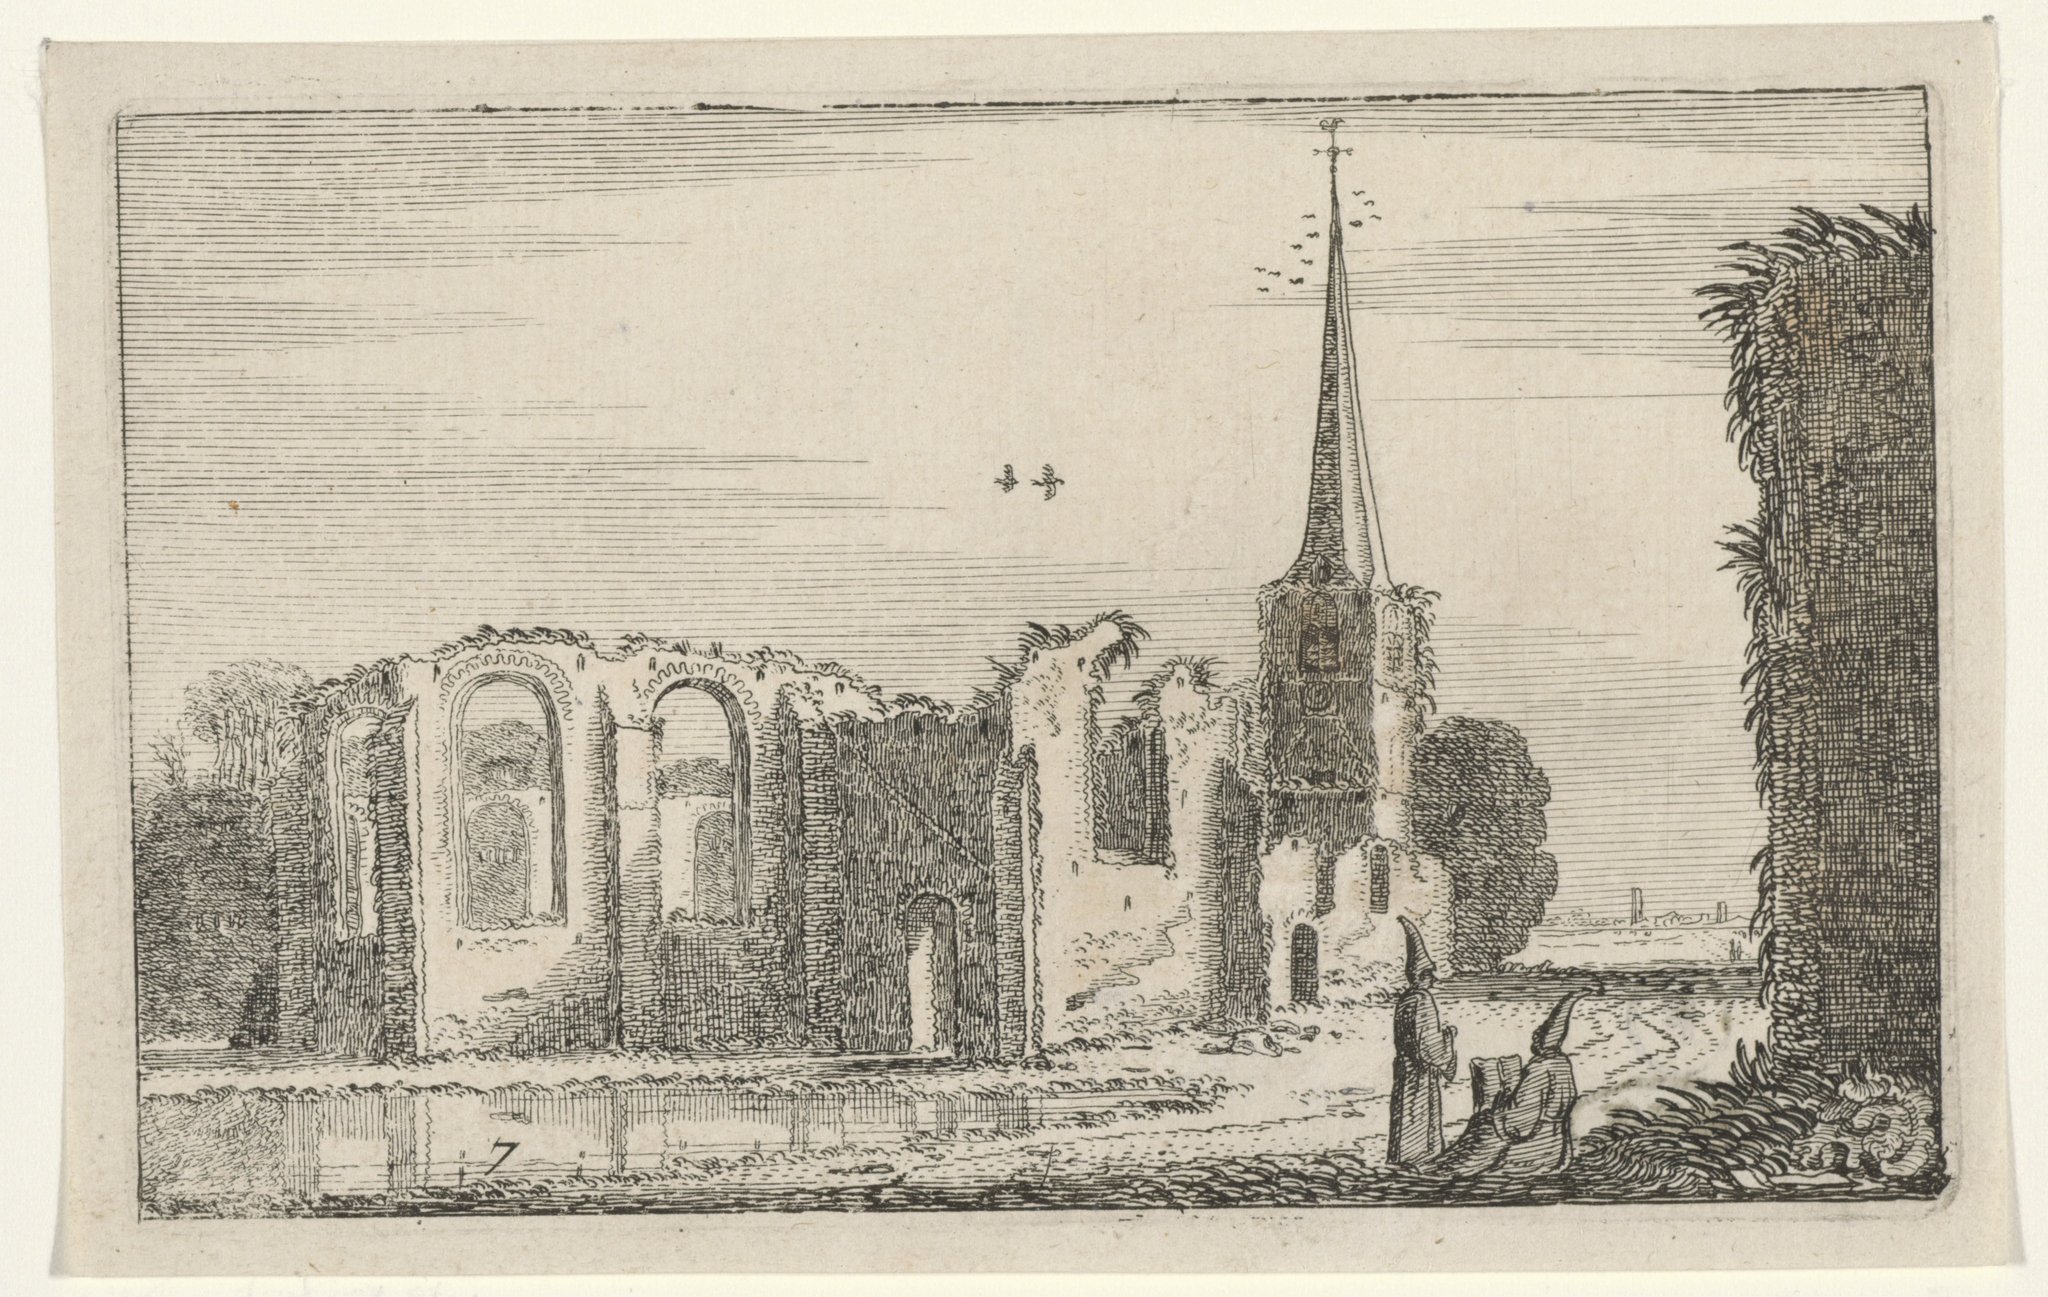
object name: print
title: Ruïnes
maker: jan van de velde (ii)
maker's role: draughtsman, painter, print maker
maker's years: 1593-1641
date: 1616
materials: paper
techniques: engraving, etching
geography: northern netherlands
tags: landscape with ruins, monk(s), friar(s), ruin of church, monastery, etc.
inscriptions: collector's mark: Lugt 964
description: Twee converserende kloosterlingen langs een pad bij een ruïne van een kerkgebouw. Zevende prent uit een serie van twintig.